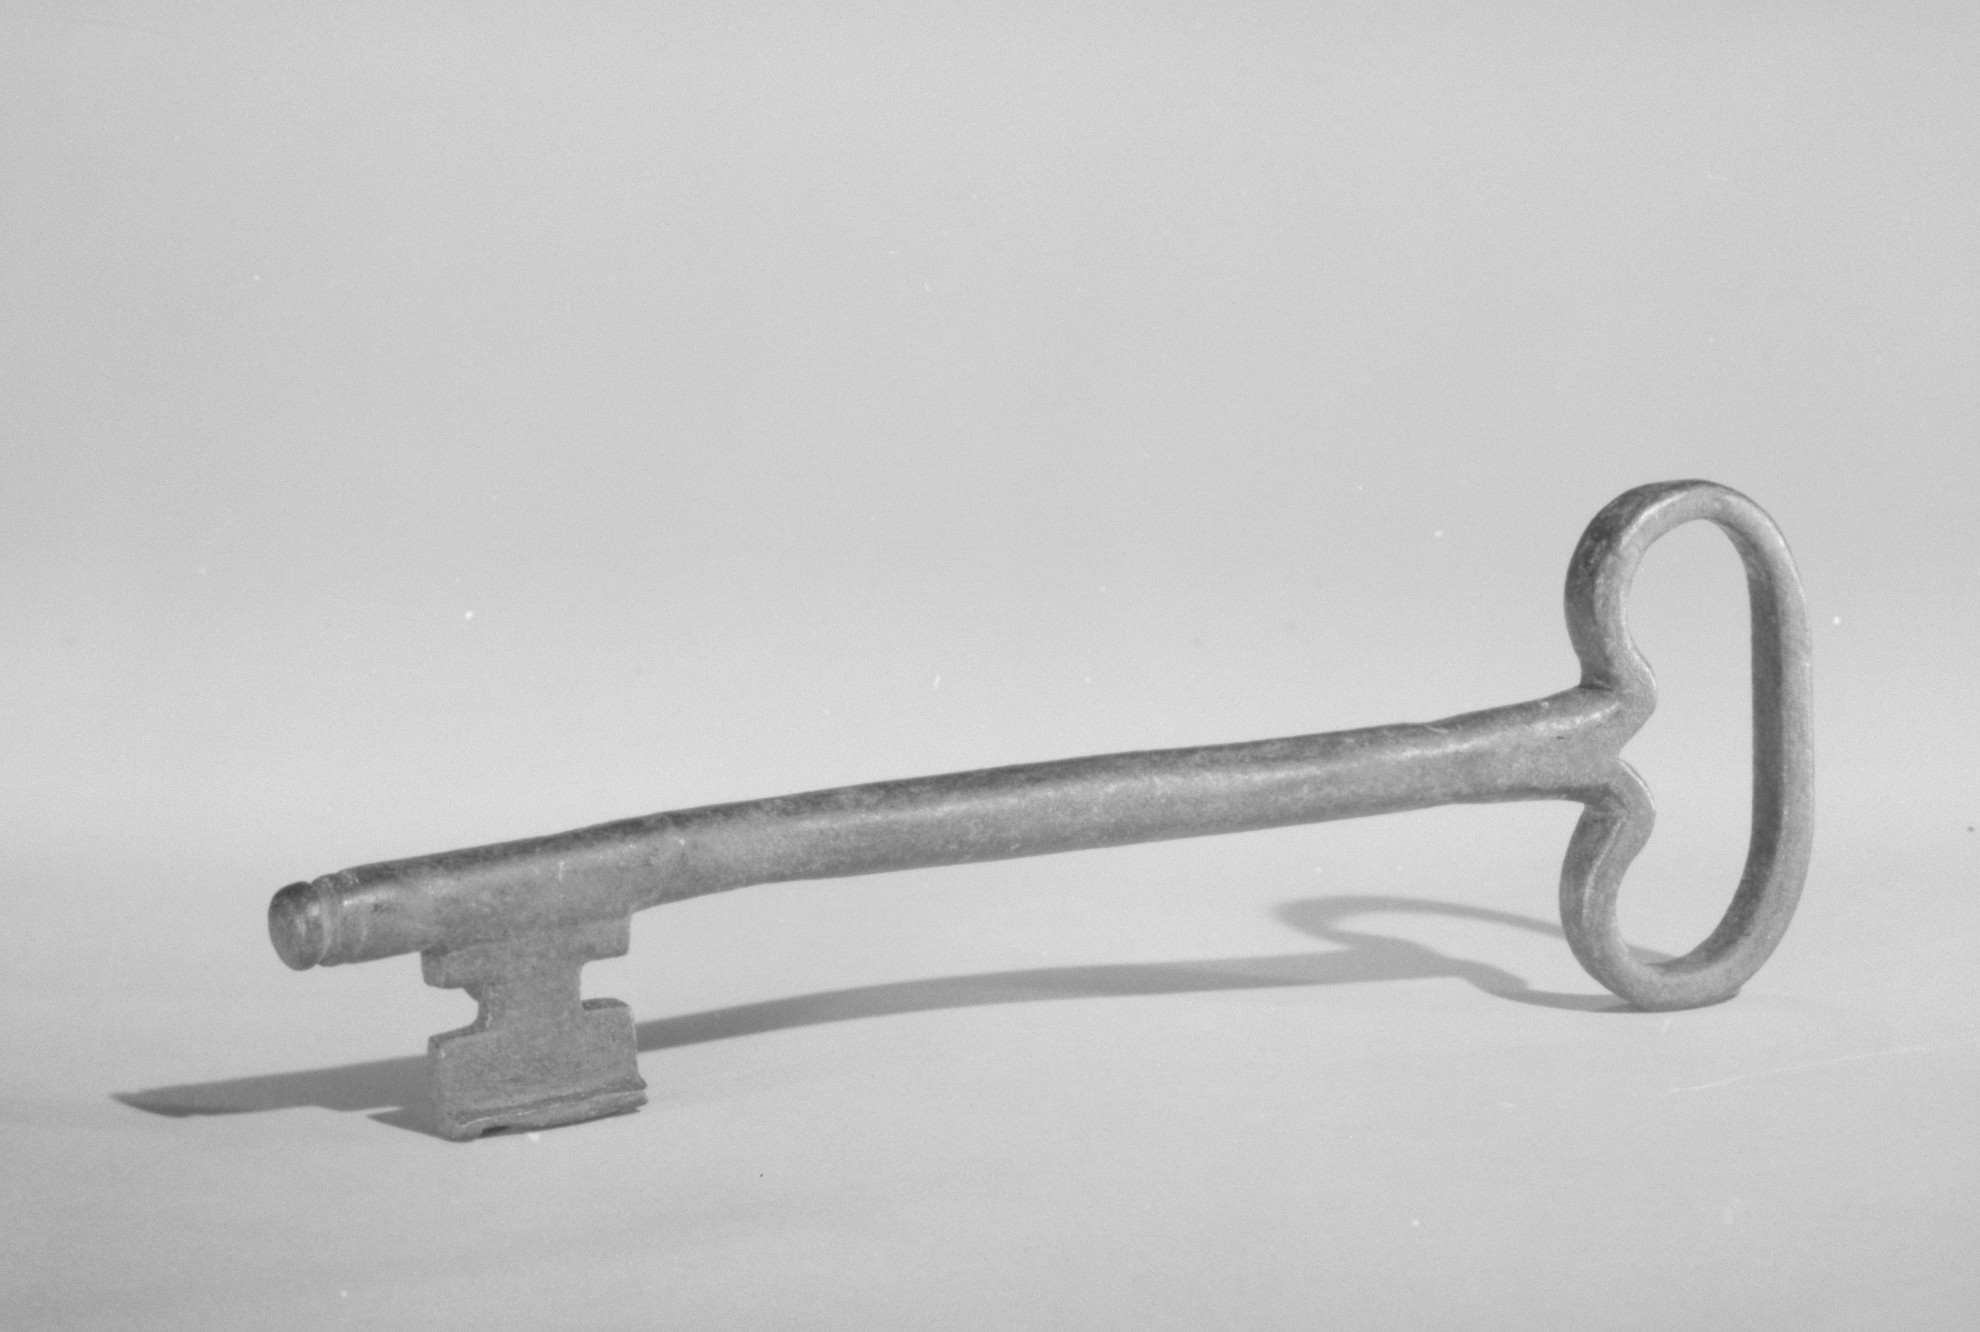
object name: key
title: Pin key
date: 1601-1800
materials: iron